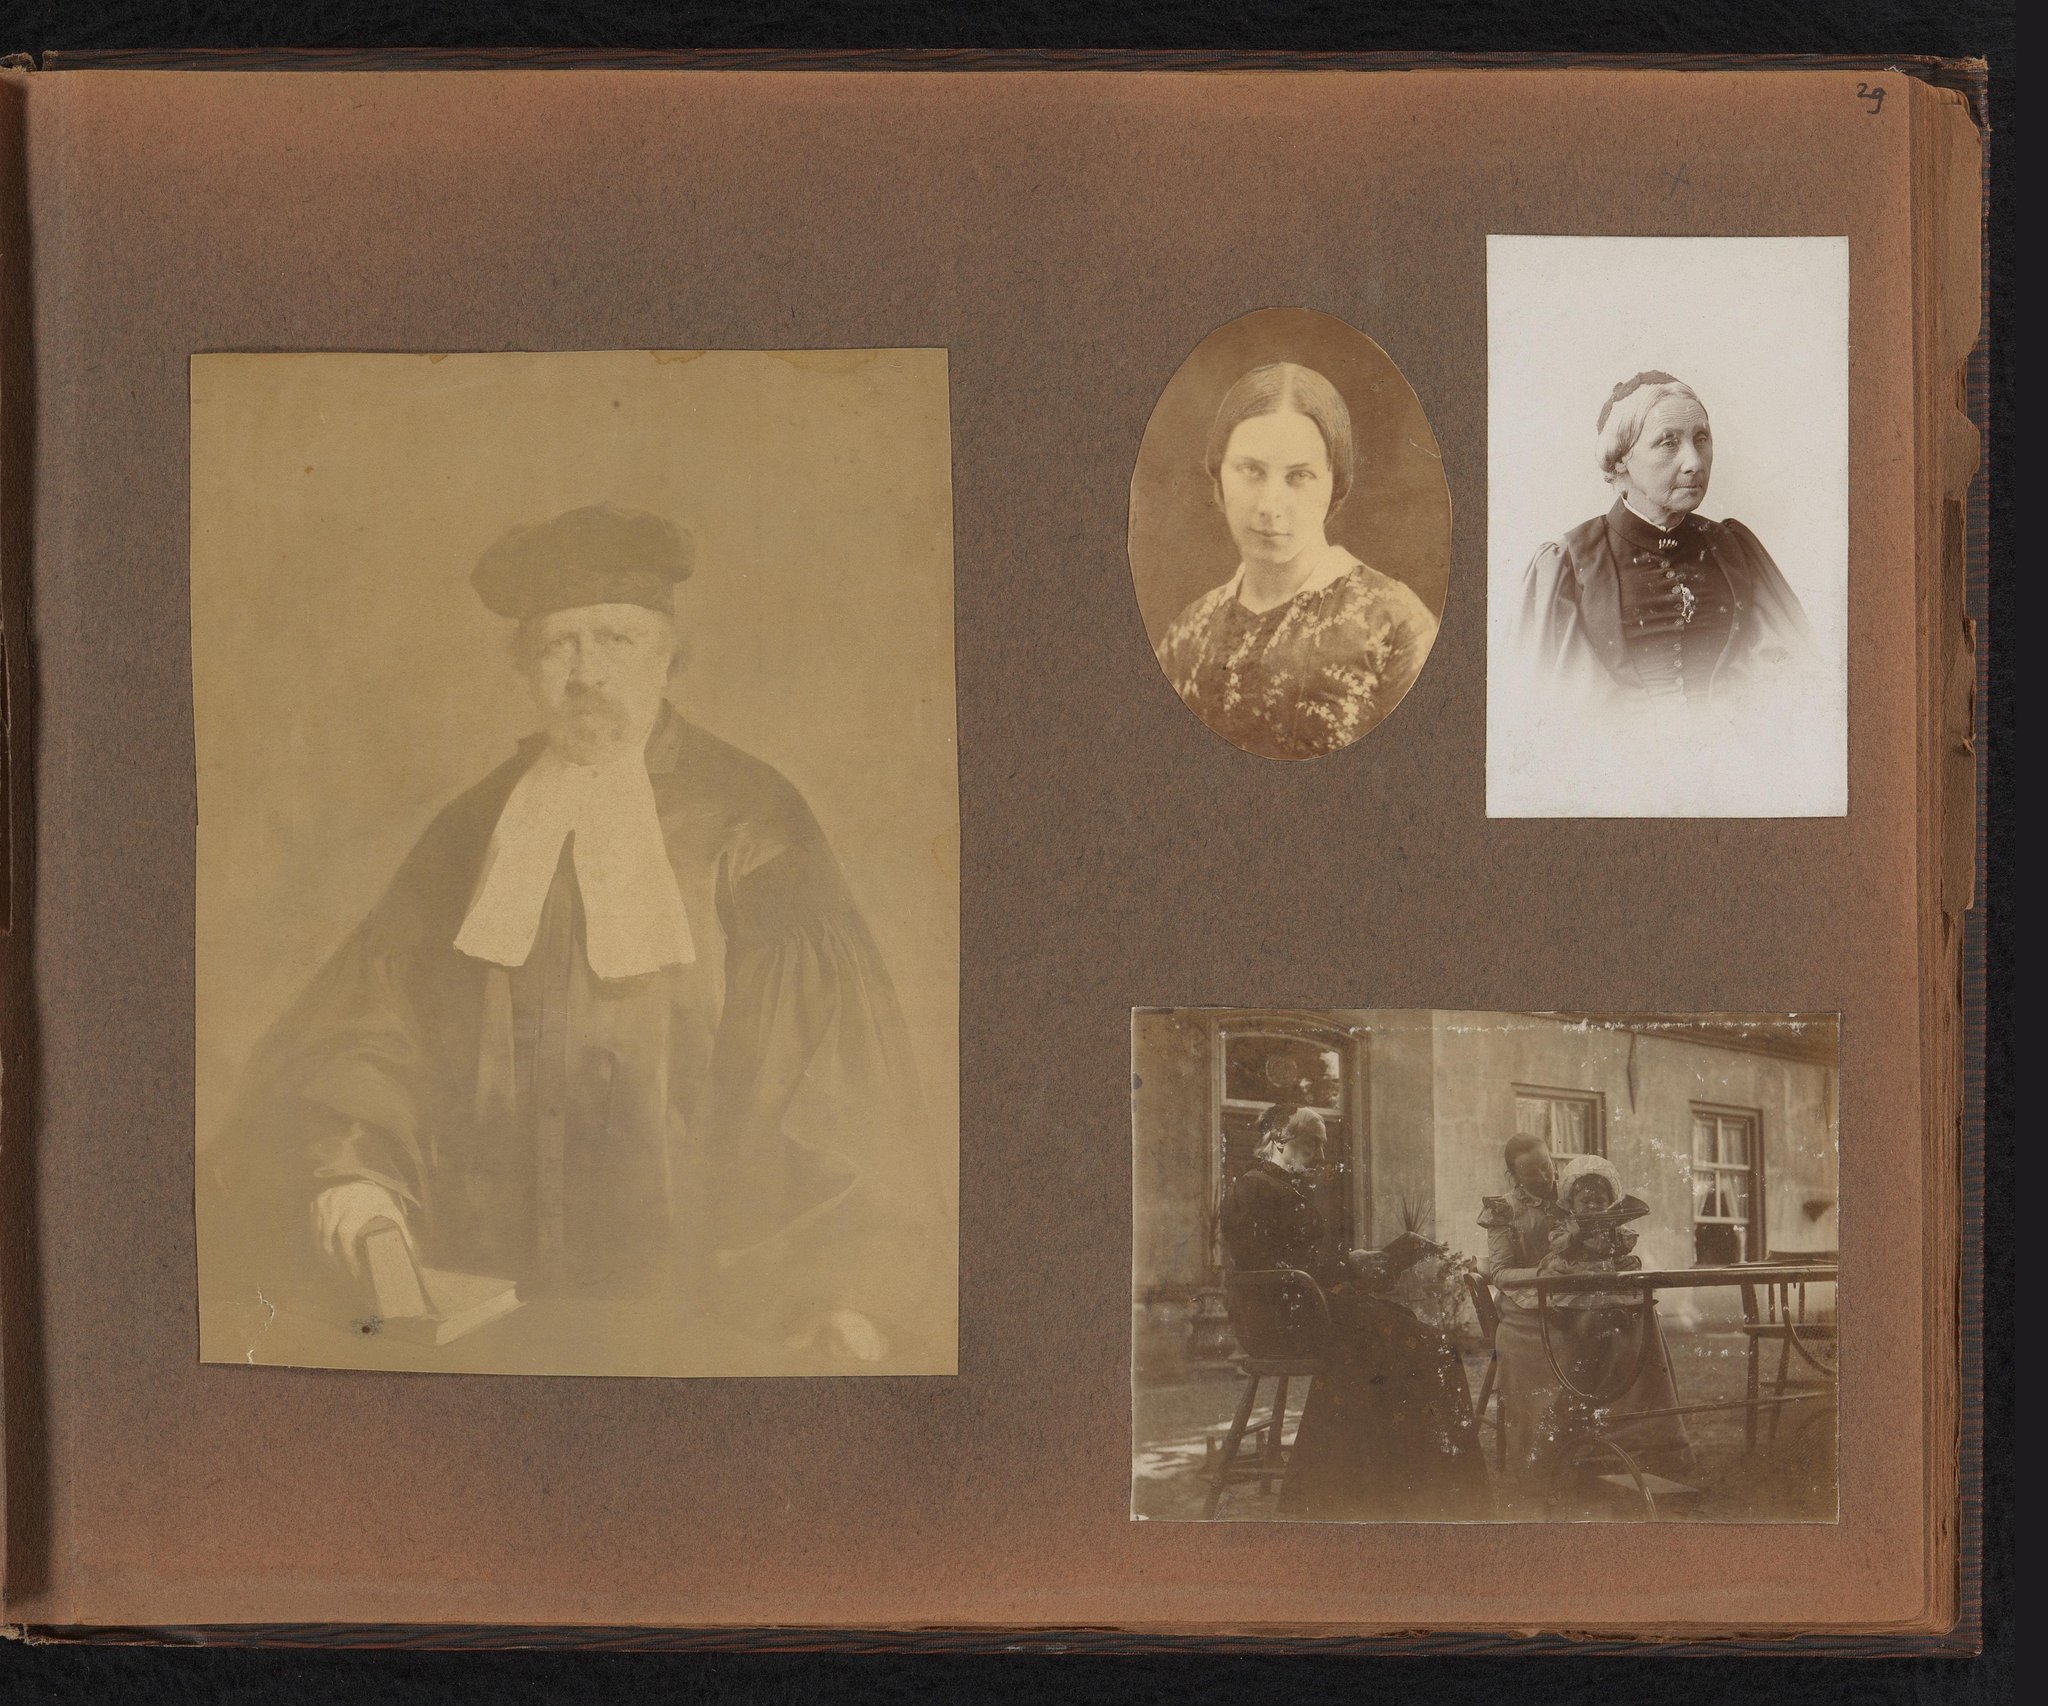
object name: photograph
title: Bladzijde uit het fotoalbum van de familie Diepenbrock met 5 foto's van Alphons Diepenbrock en zijn omgeving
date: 1870-1920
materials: cardboard, photographic support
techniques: photography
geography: netherlands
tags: netherlands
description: Bruin albumblad 29 van familiealbum van Alphons Diepenbrock.